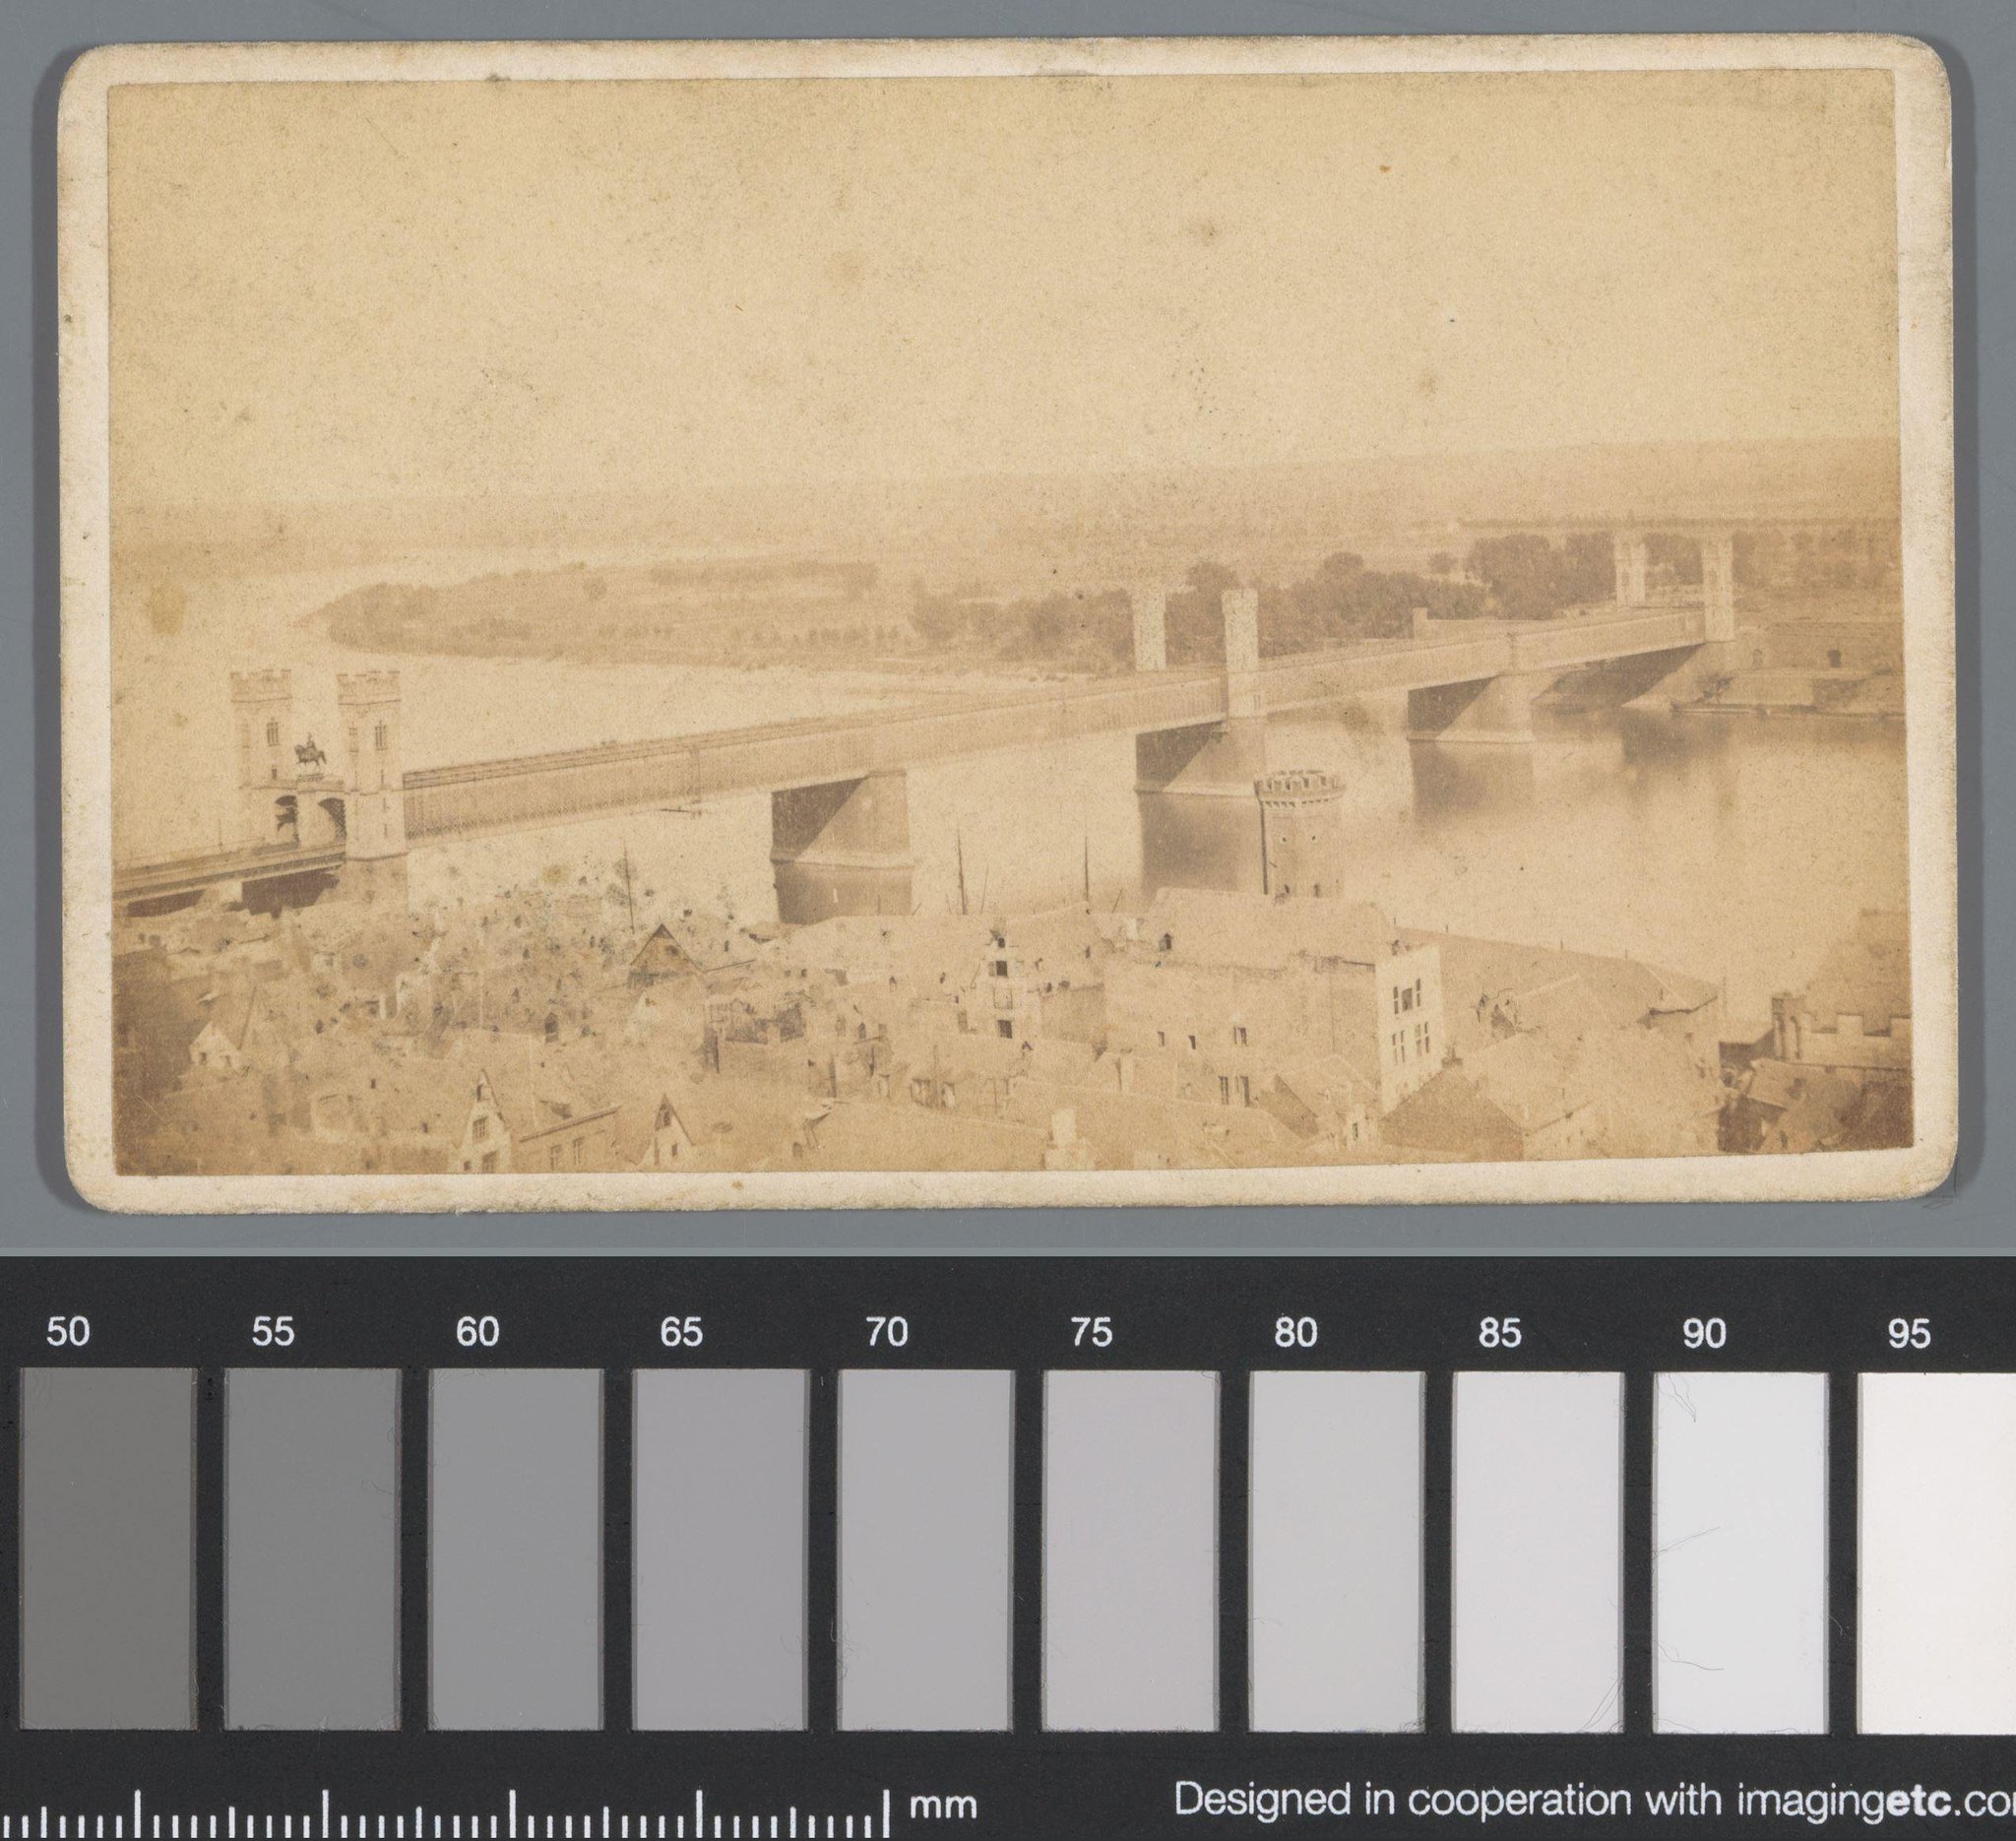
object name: photograph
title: Dombrücke in Keulen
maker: Anonymous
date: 1859-1875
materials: cardboard, paper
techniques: albumen print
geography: cologne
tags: bridge in city across river, canal, etc.